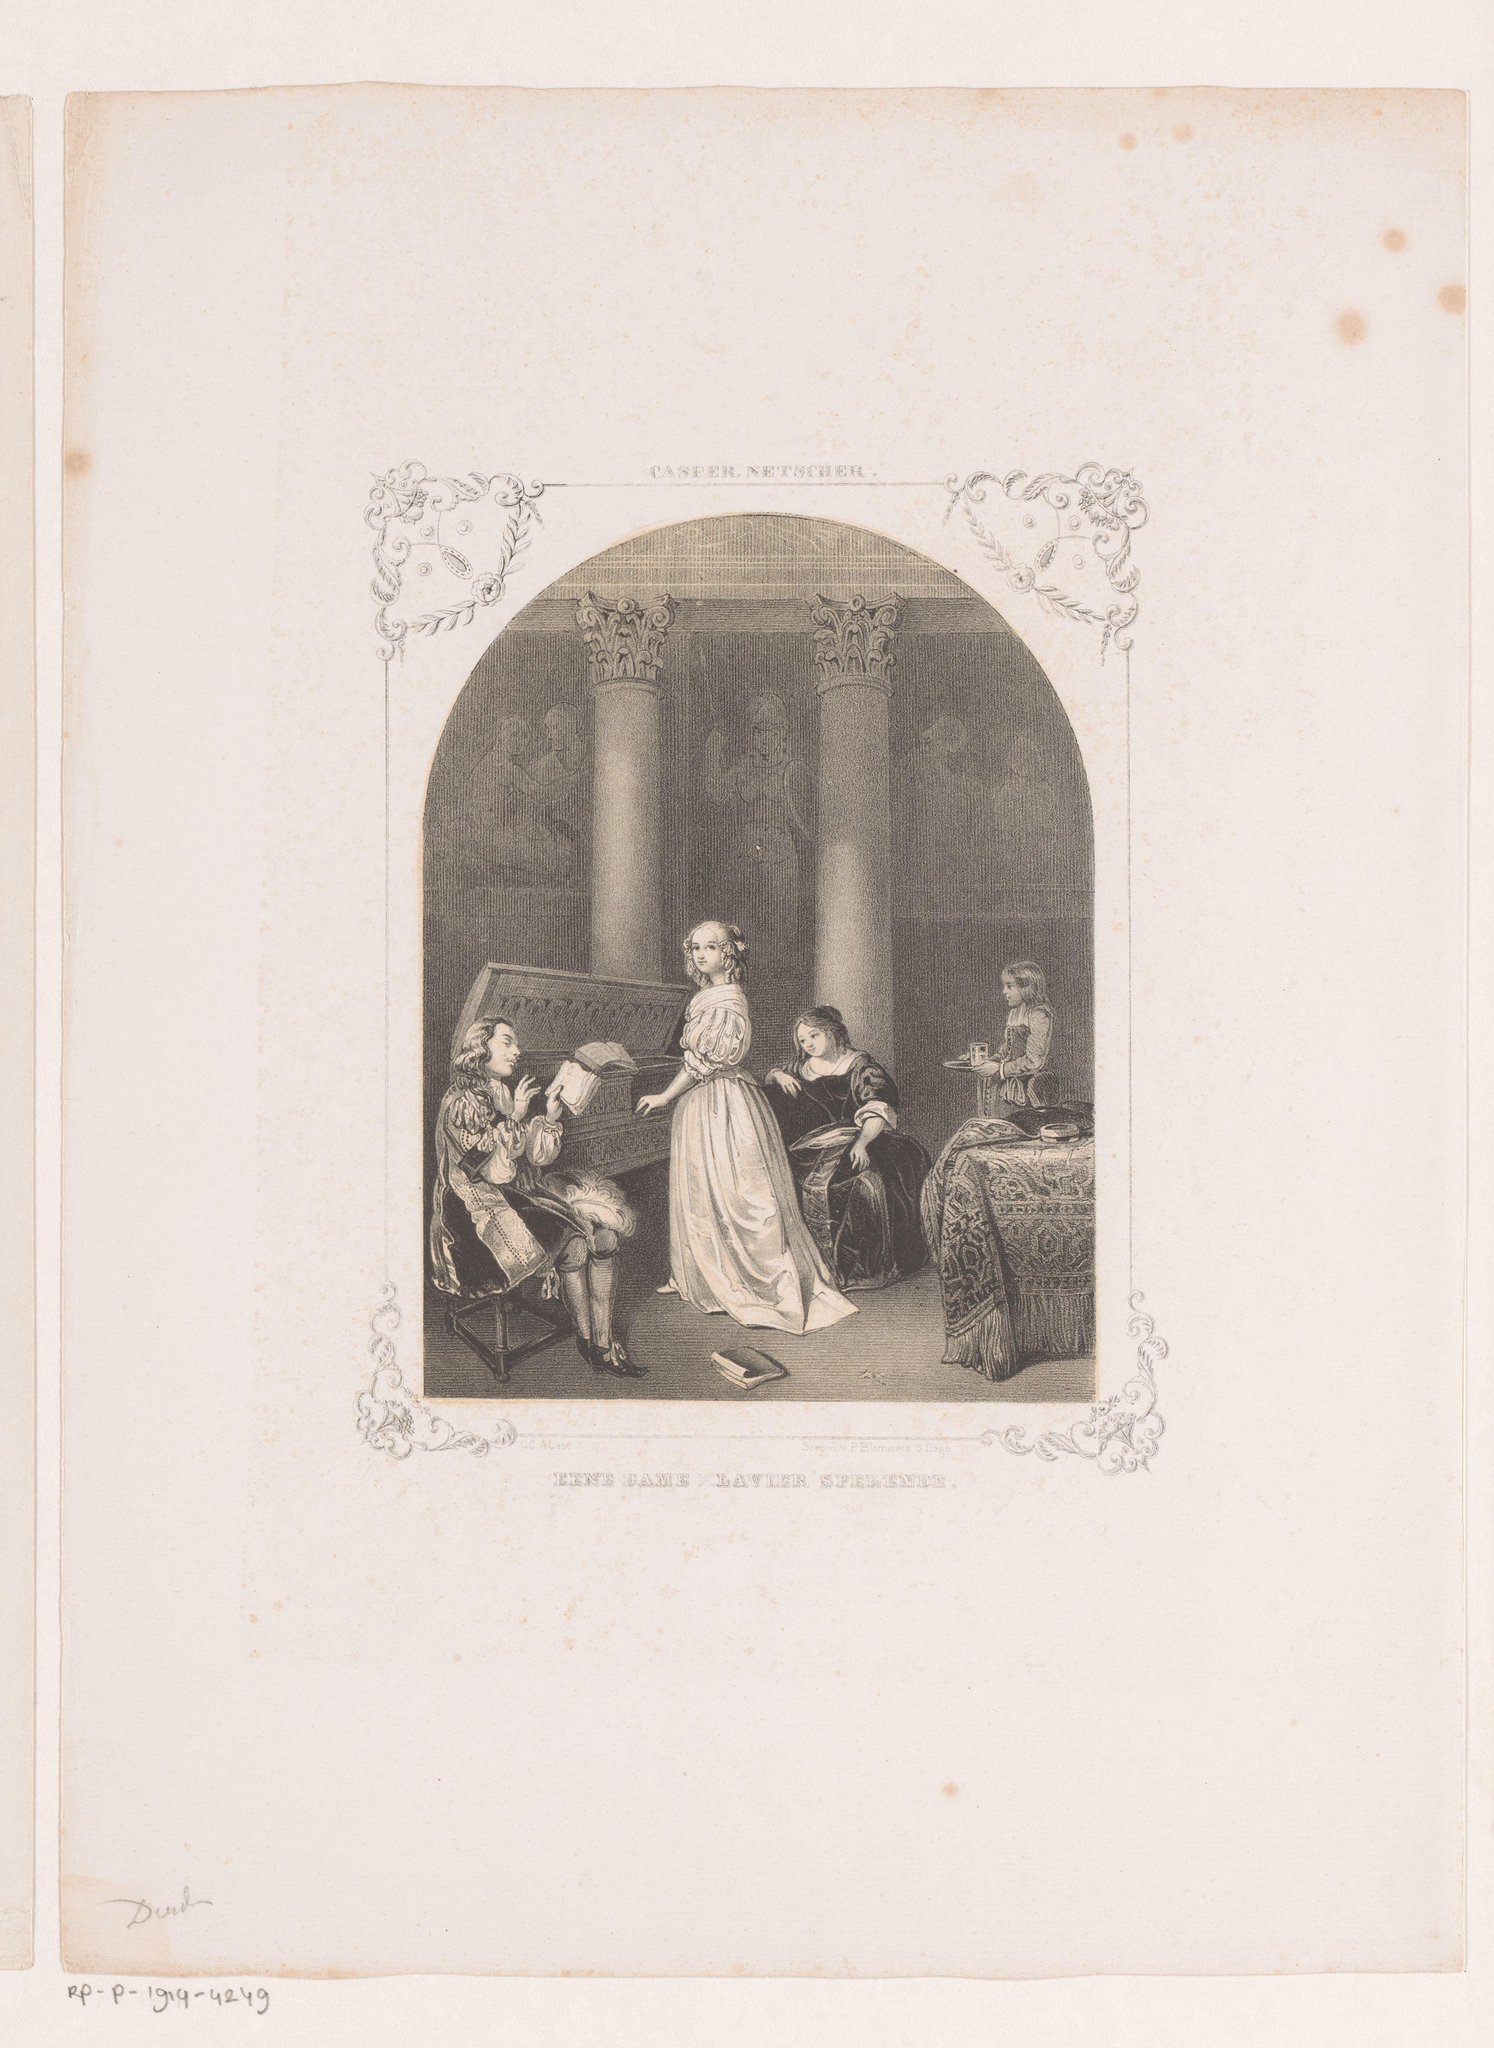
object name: print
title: Eene dame klavier spelende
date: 1843-1876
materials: paper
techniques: tone lithography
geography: the hague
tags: musician training pupils, music-lesson, spinet, virginal, capital (~ column, pillar), corinthian order ~ architecture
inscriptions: collector's mark: Lugt 2228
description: Een vrouw staat met haar handen op de toetsen van een instrument, mogelijk een virginaal. Naast haar een man en een vrouw, rechts komt een bediende een glas brengen. Achter het gezelschap twee zuilen met Korintische kapitelen.